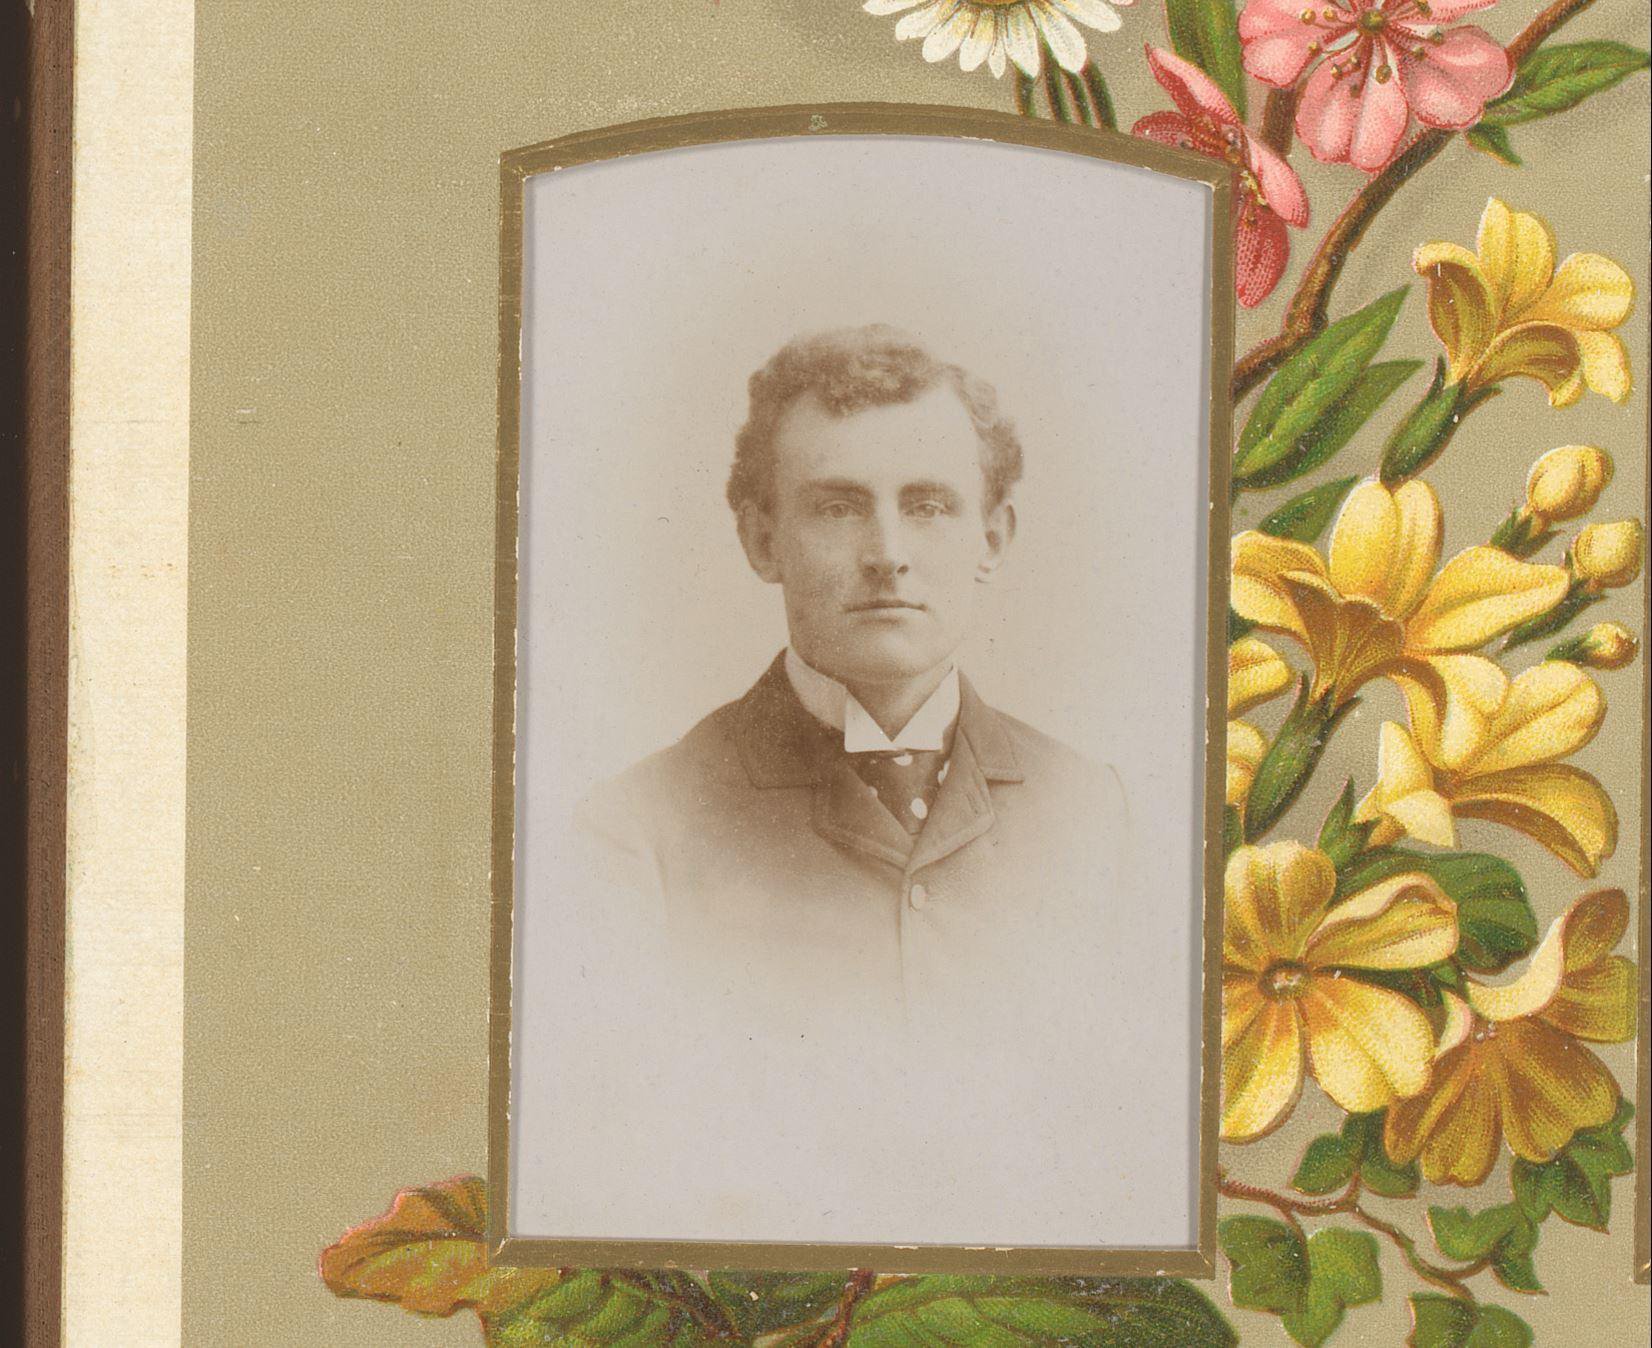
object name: album leaf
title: Portret van een man, aangeduid als J.H. Kruyk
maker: jacques chits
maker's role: fotograaf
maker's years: 1835-1917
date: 1884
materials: cardboard, photographic support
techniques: albumen print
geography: haarlem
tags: historical persons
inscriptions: inscription: ‘Photografische Inrigting JACQUES CHITS/ Waaigat No 14, by de Kruisstraat HAARLEM/ De plaat blijft ter nabestelling bewaard’, annotation: ‘in dank[...]/ [...] 19 Maart/ 1884/ Haarlem/ J.H. Kruyk’